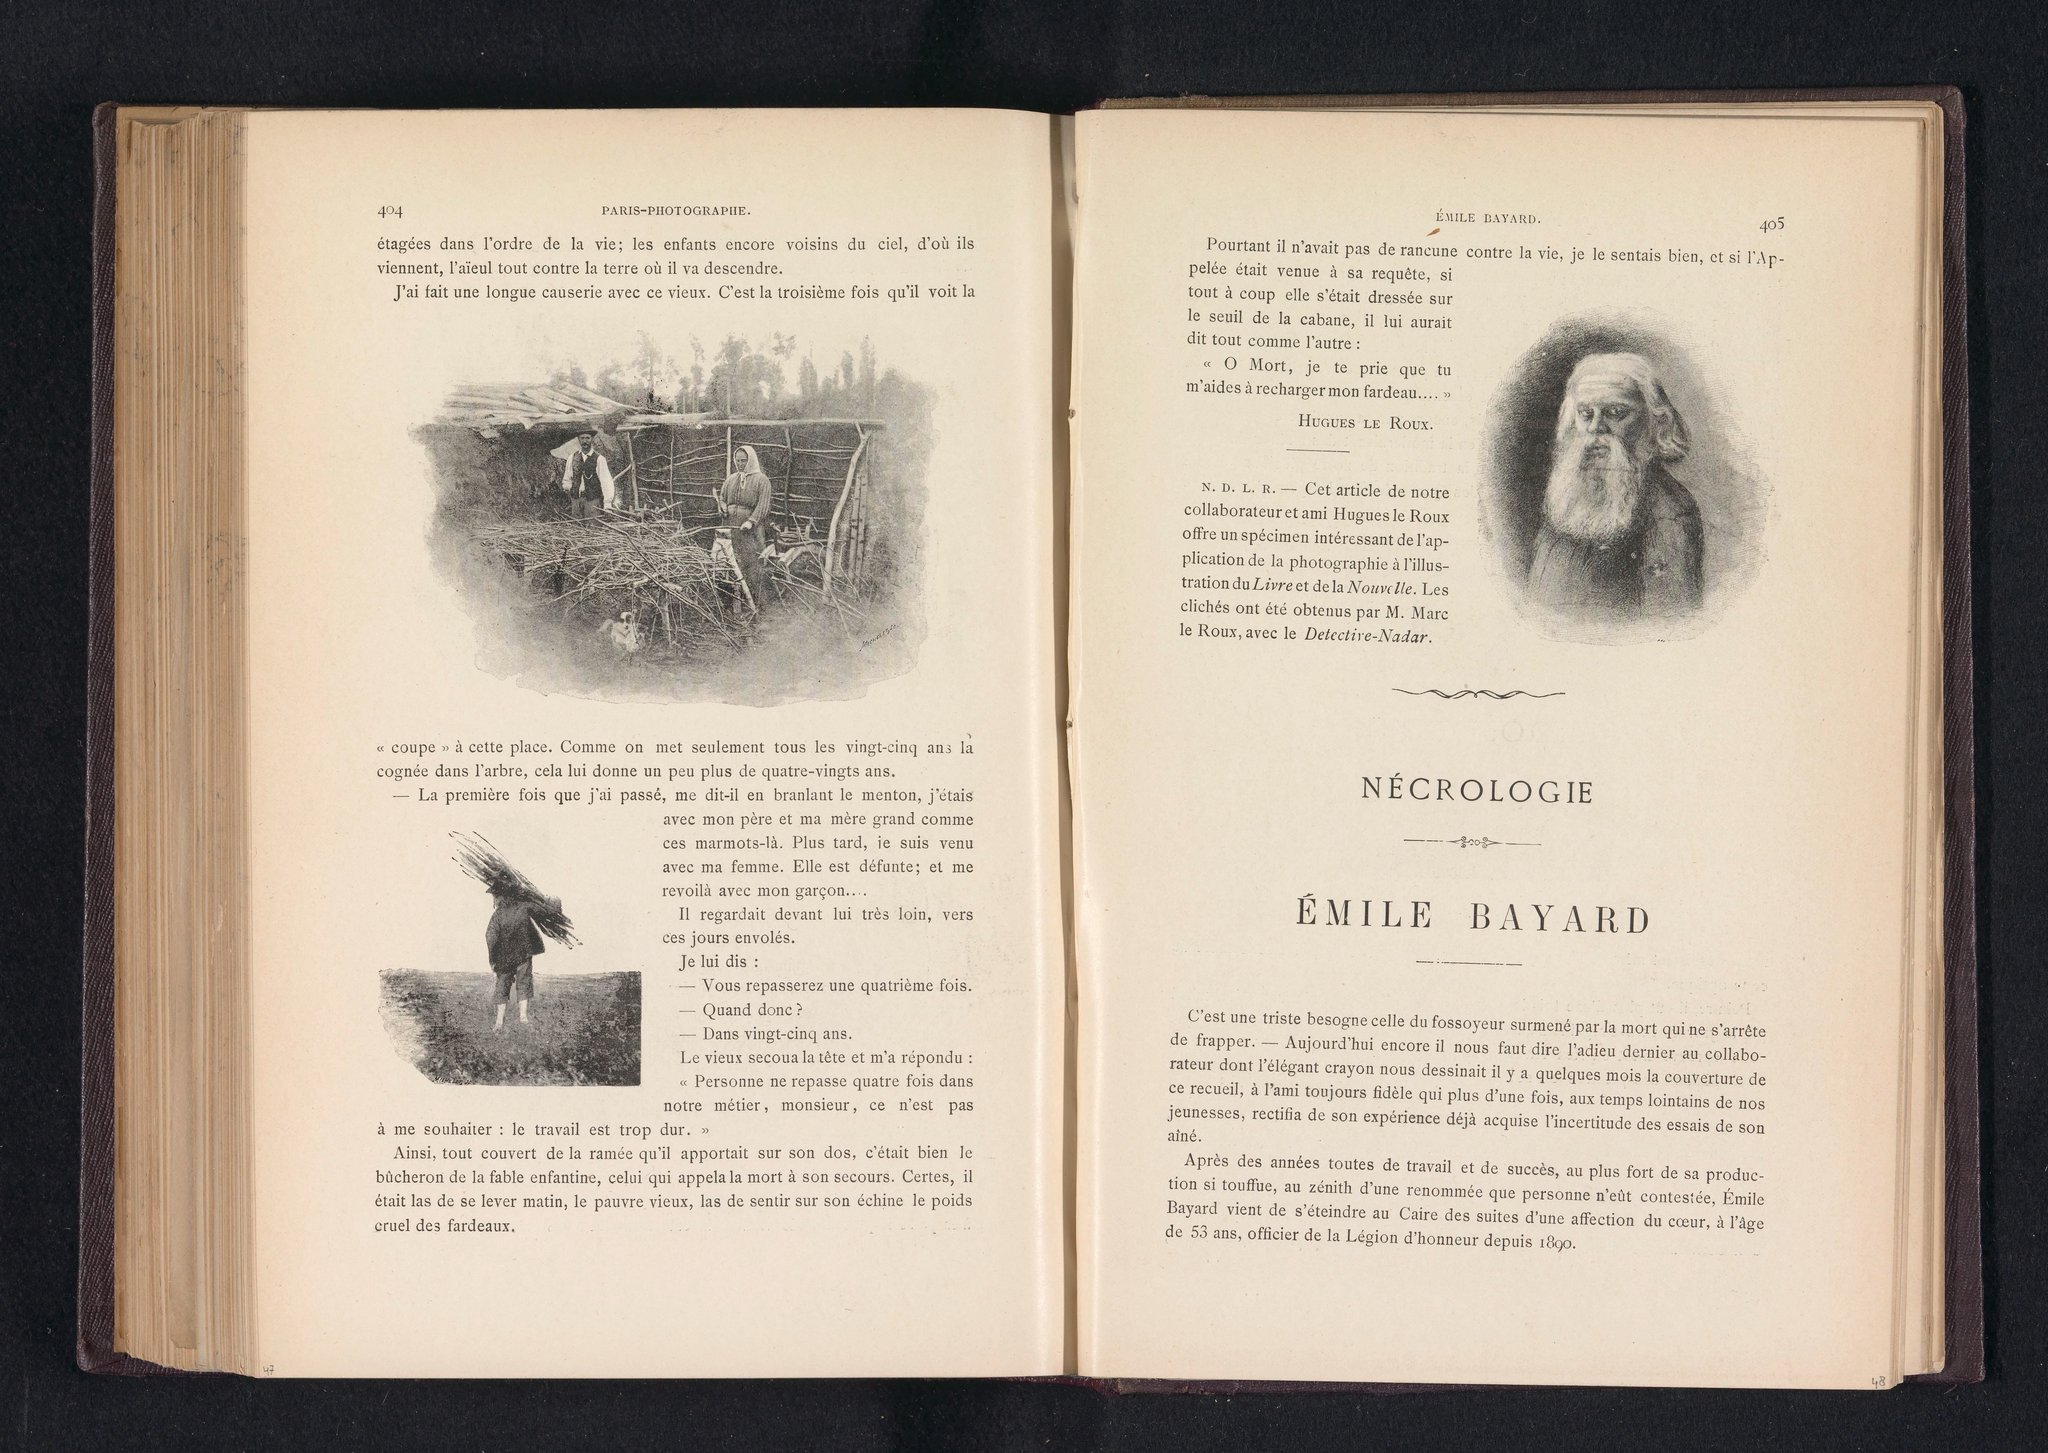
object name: page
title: Twee scenes van een boerengezin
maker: michelet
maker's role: print maker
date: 1881-1891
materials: paper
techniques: autotype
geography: france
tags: woodgathering, woodgatherer, farmers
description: Boven een boer en boerin met een stapel hout, onder een man die hout draagt.